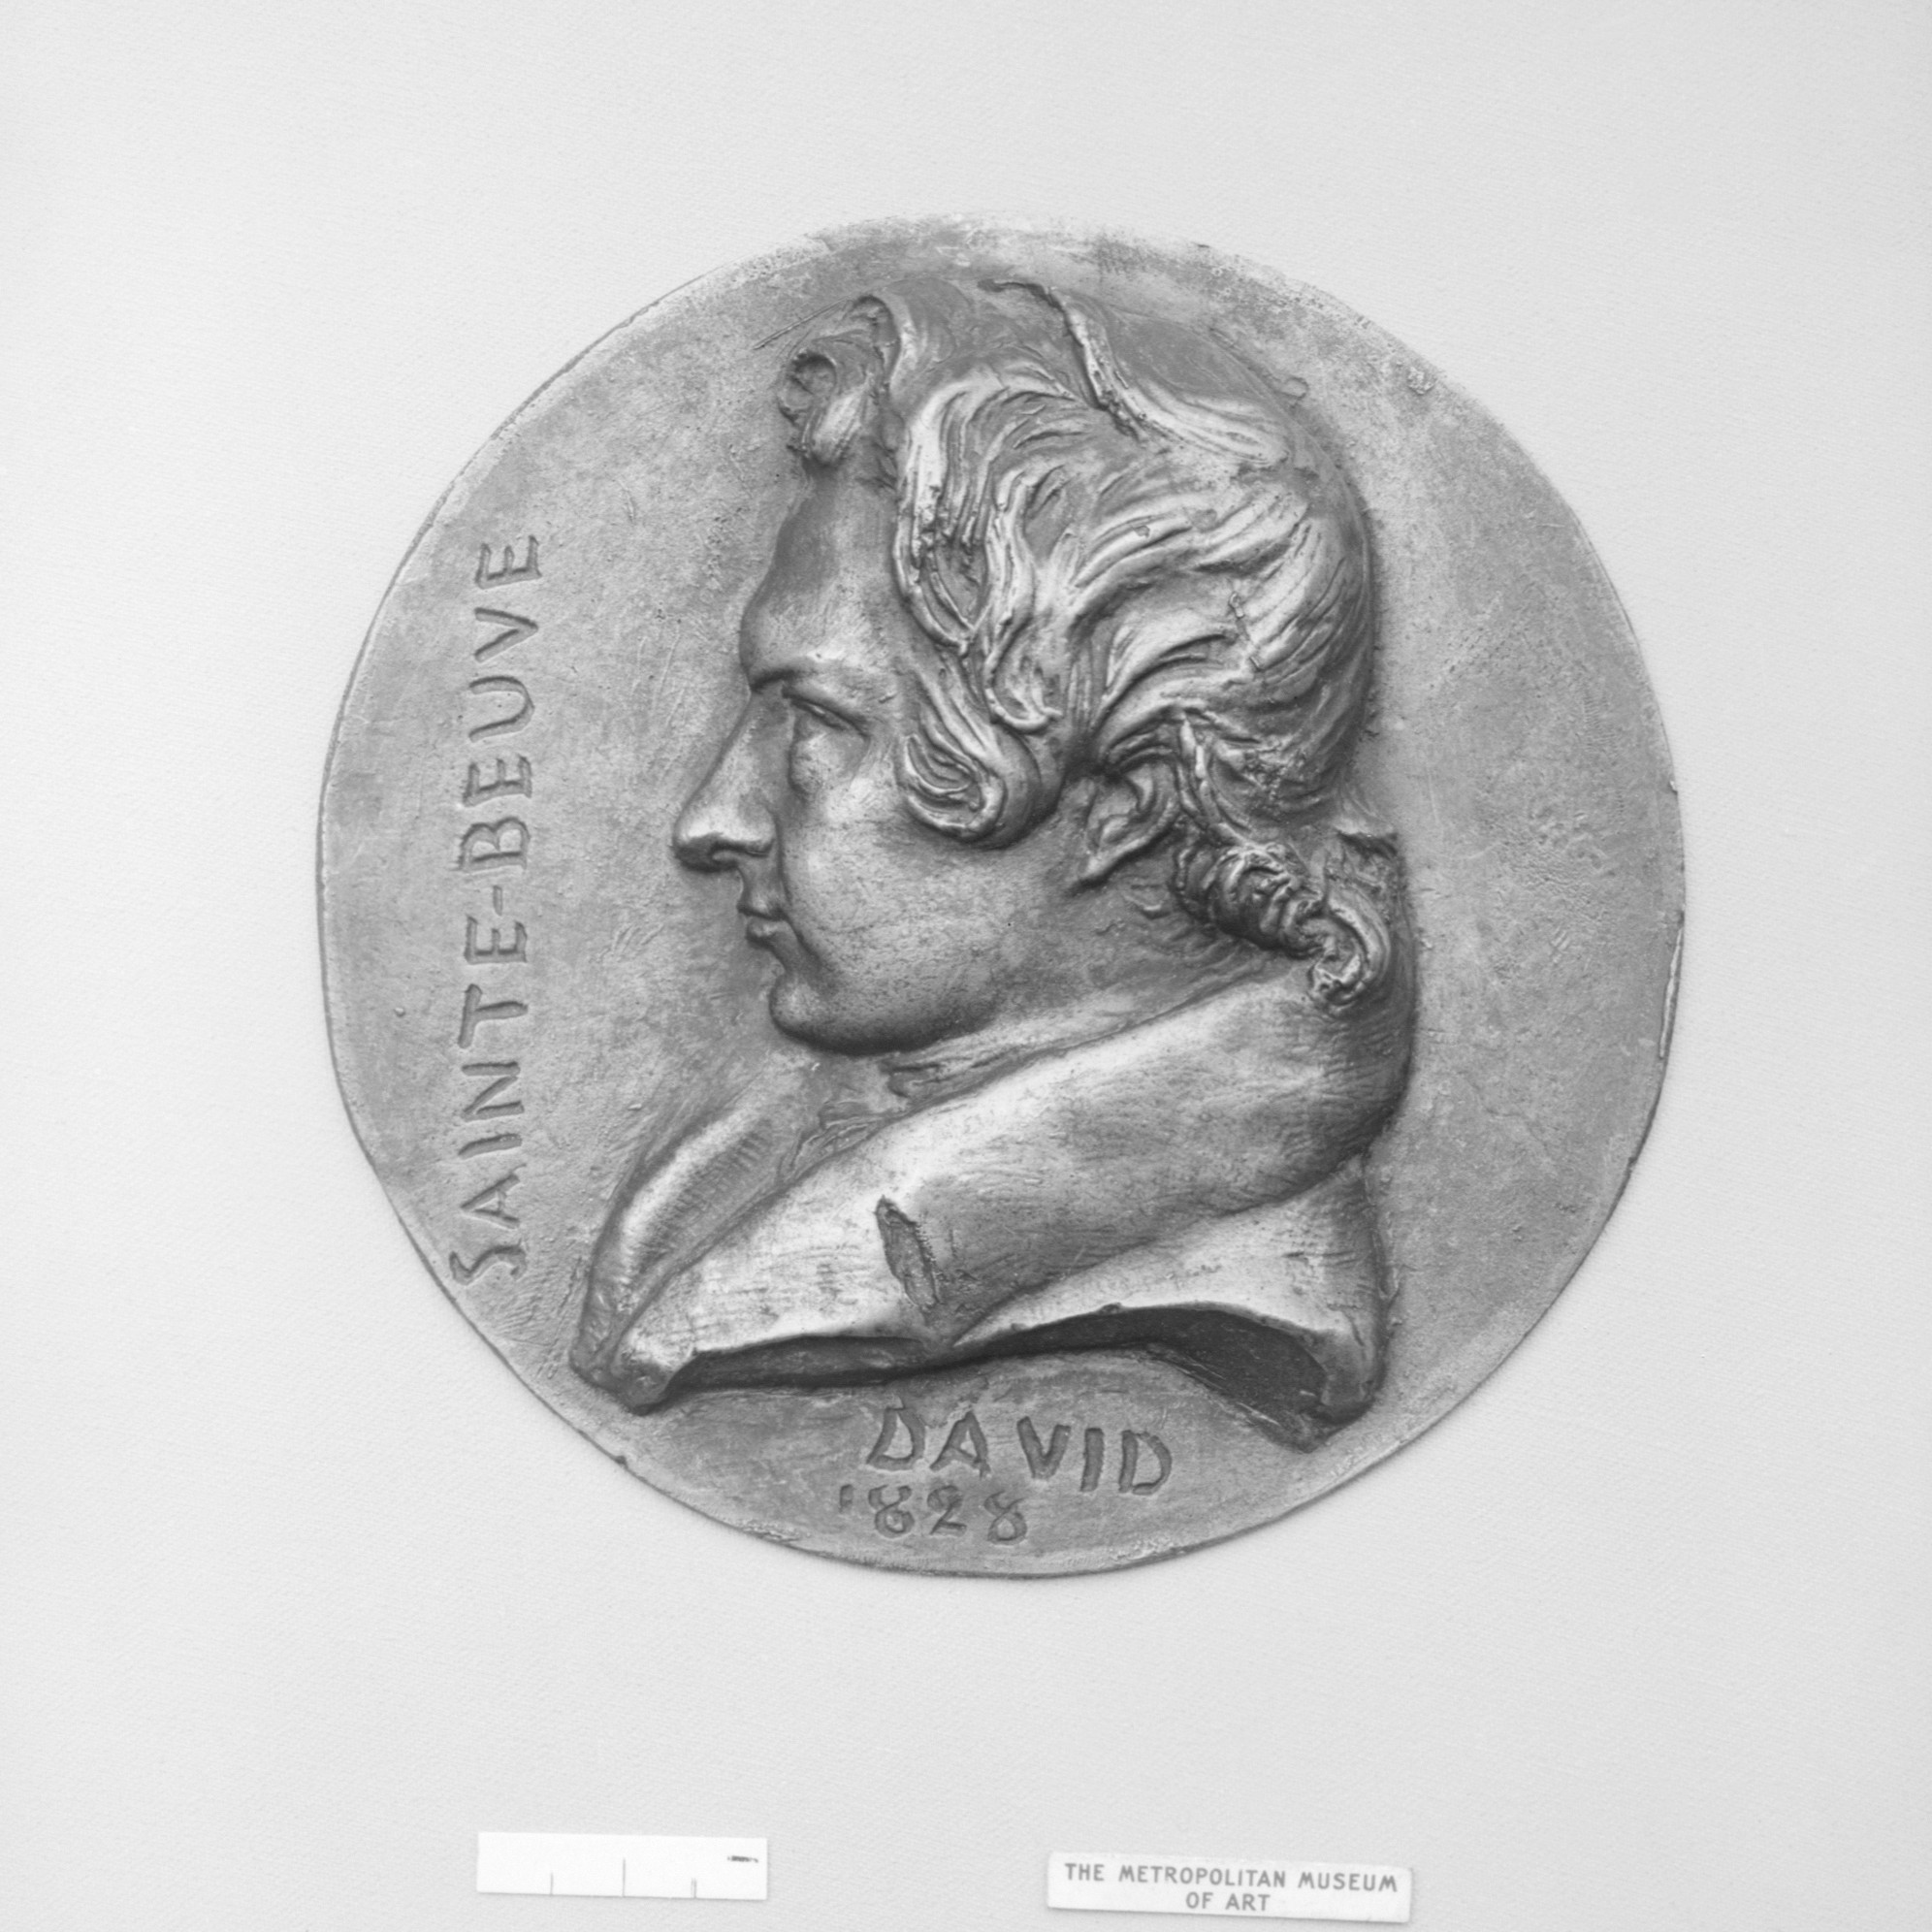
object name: medallion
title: Charles Augustin Sainte-Beuve (1804–1869), French man-of-letters and Academician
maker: pierre jean david d'angers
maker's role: artist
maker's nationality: french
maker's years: 1788-1856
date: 1828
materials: bronze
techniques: casting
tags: men,profiles